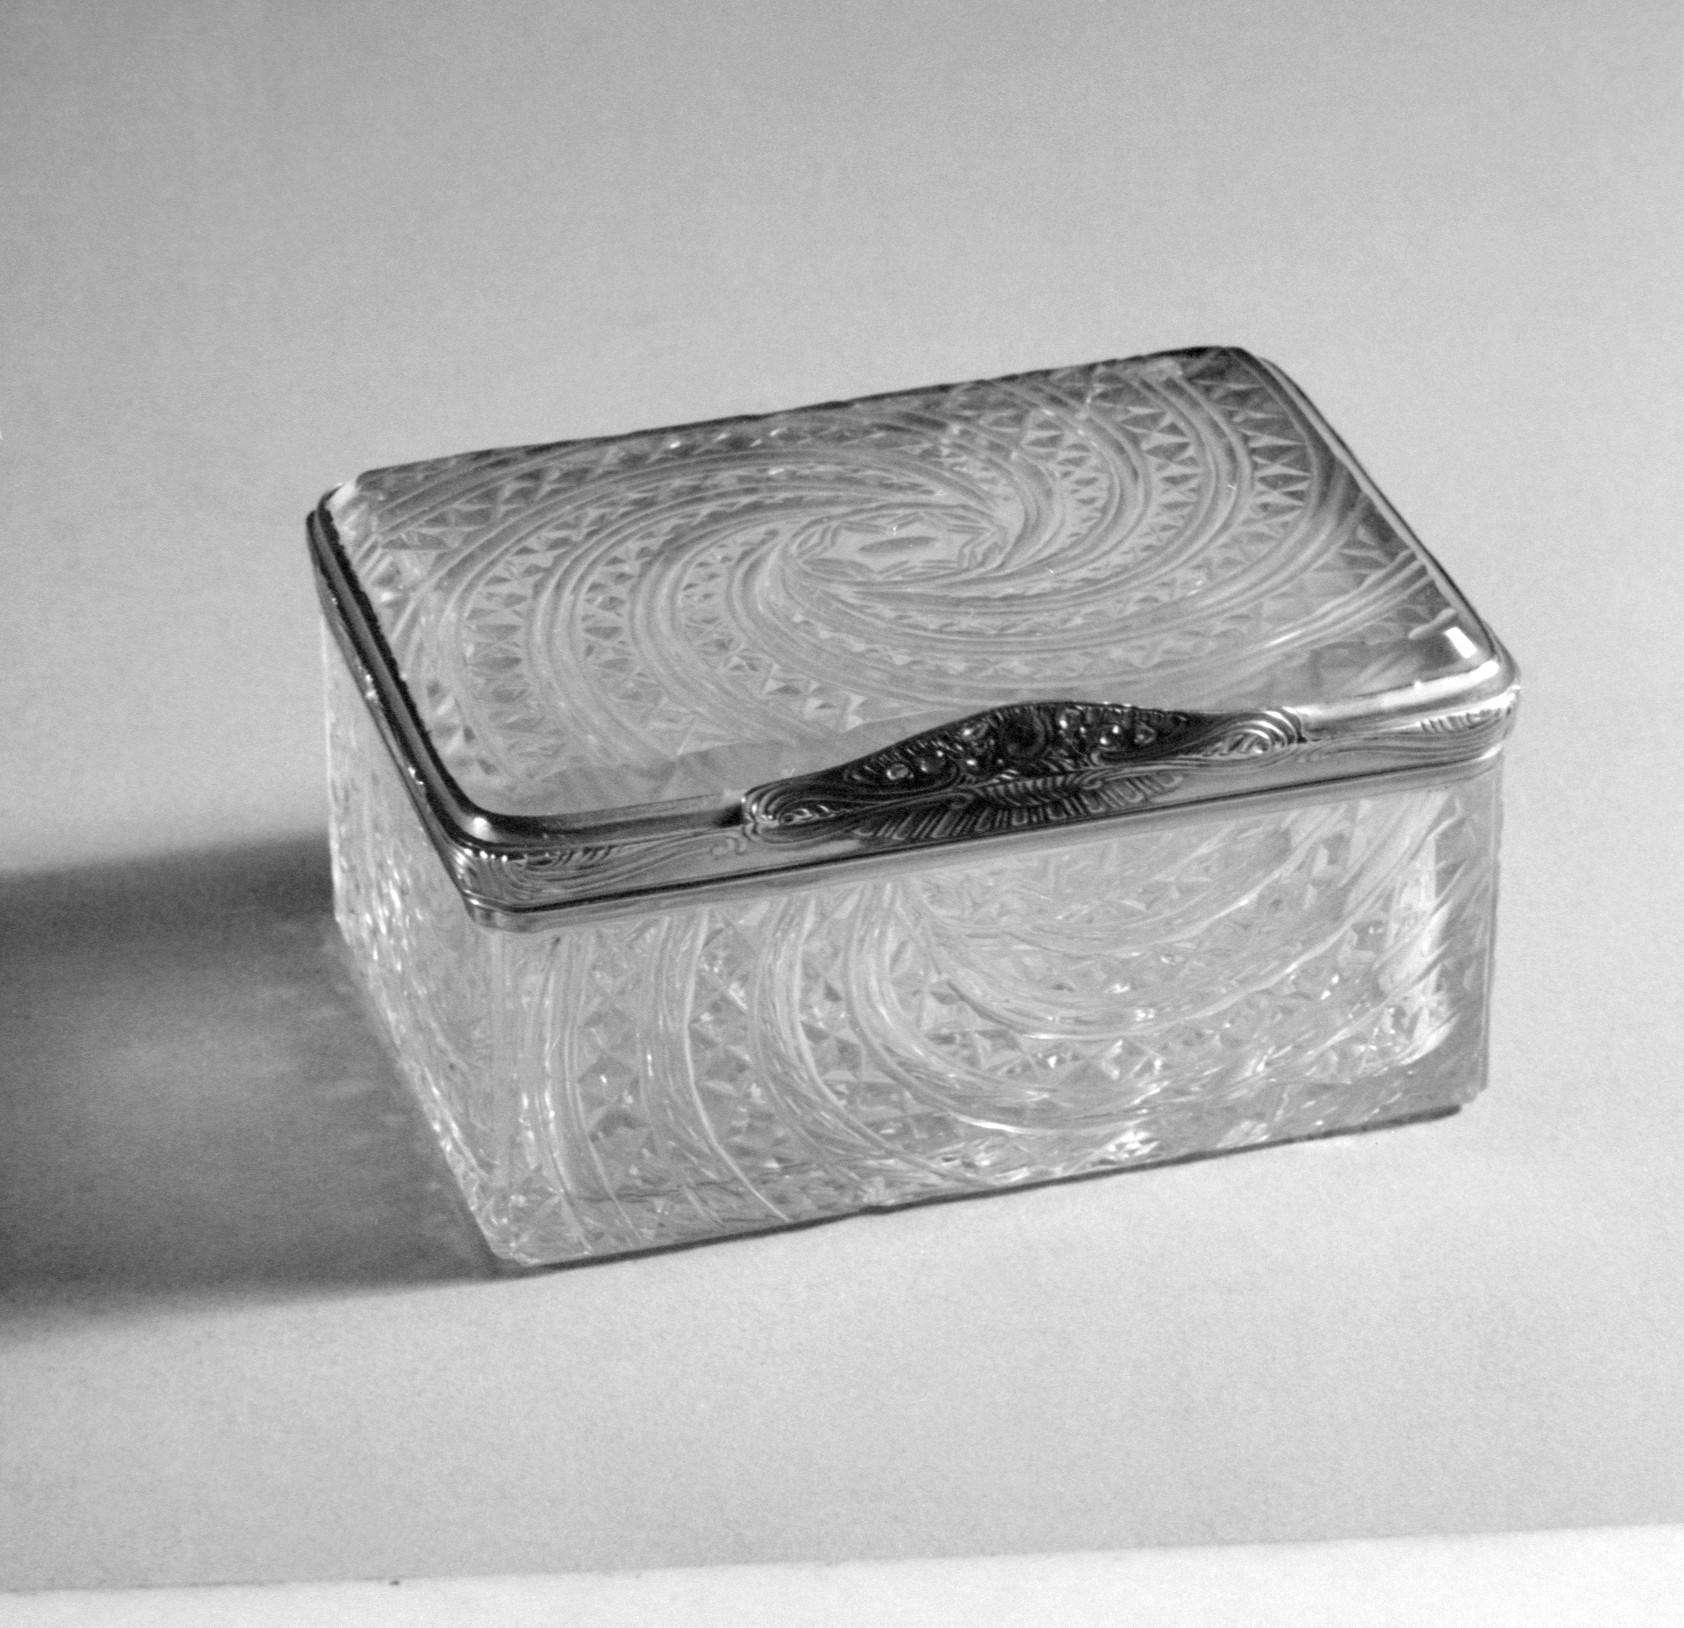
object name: snuffbox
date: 1801-1900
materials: gold, quartz